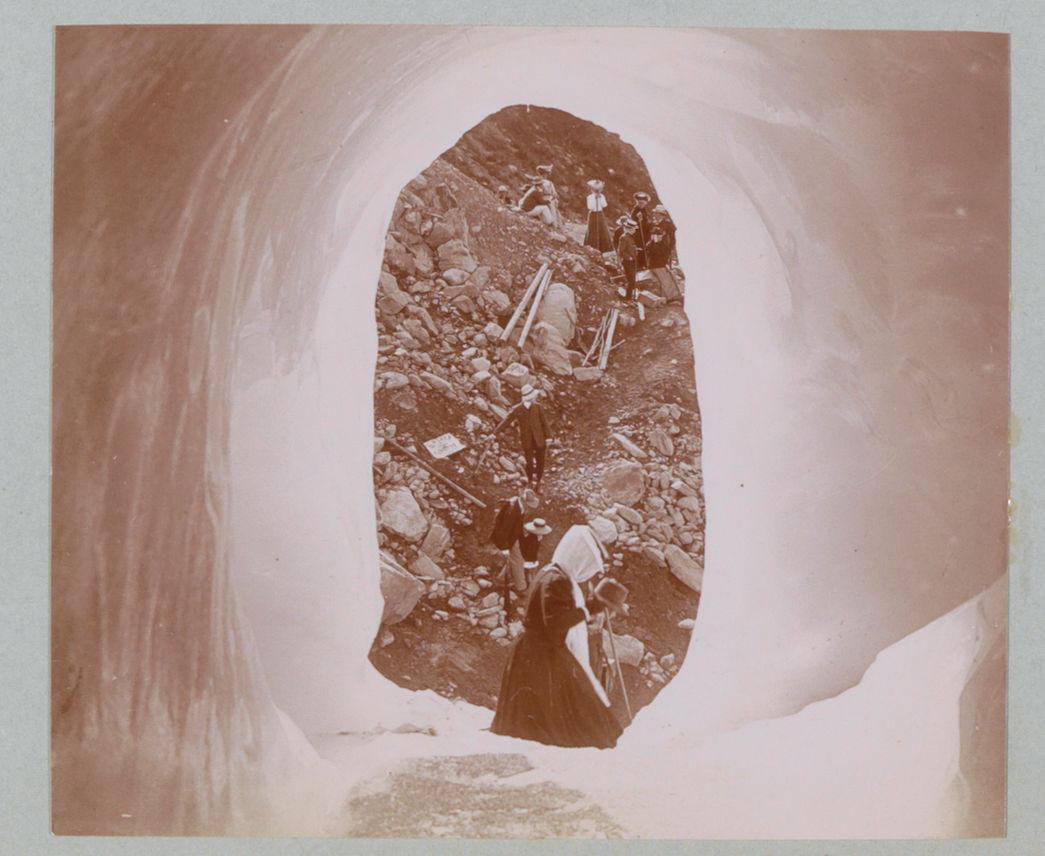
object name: photograph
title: Wandelaars in de Alpen, gezien door een gat in het ijs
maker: Anonymous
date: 1905-1910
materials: paper, photographic support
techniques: gelatin silver print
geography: alps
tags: walking, hiking (recreation), glacier, ice ~ state of water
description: Onderdeel van Fotoalbum van een Franse amateurfotograaf met bezienswaardigheden in Frankrijk, Zwitserland en Italië.